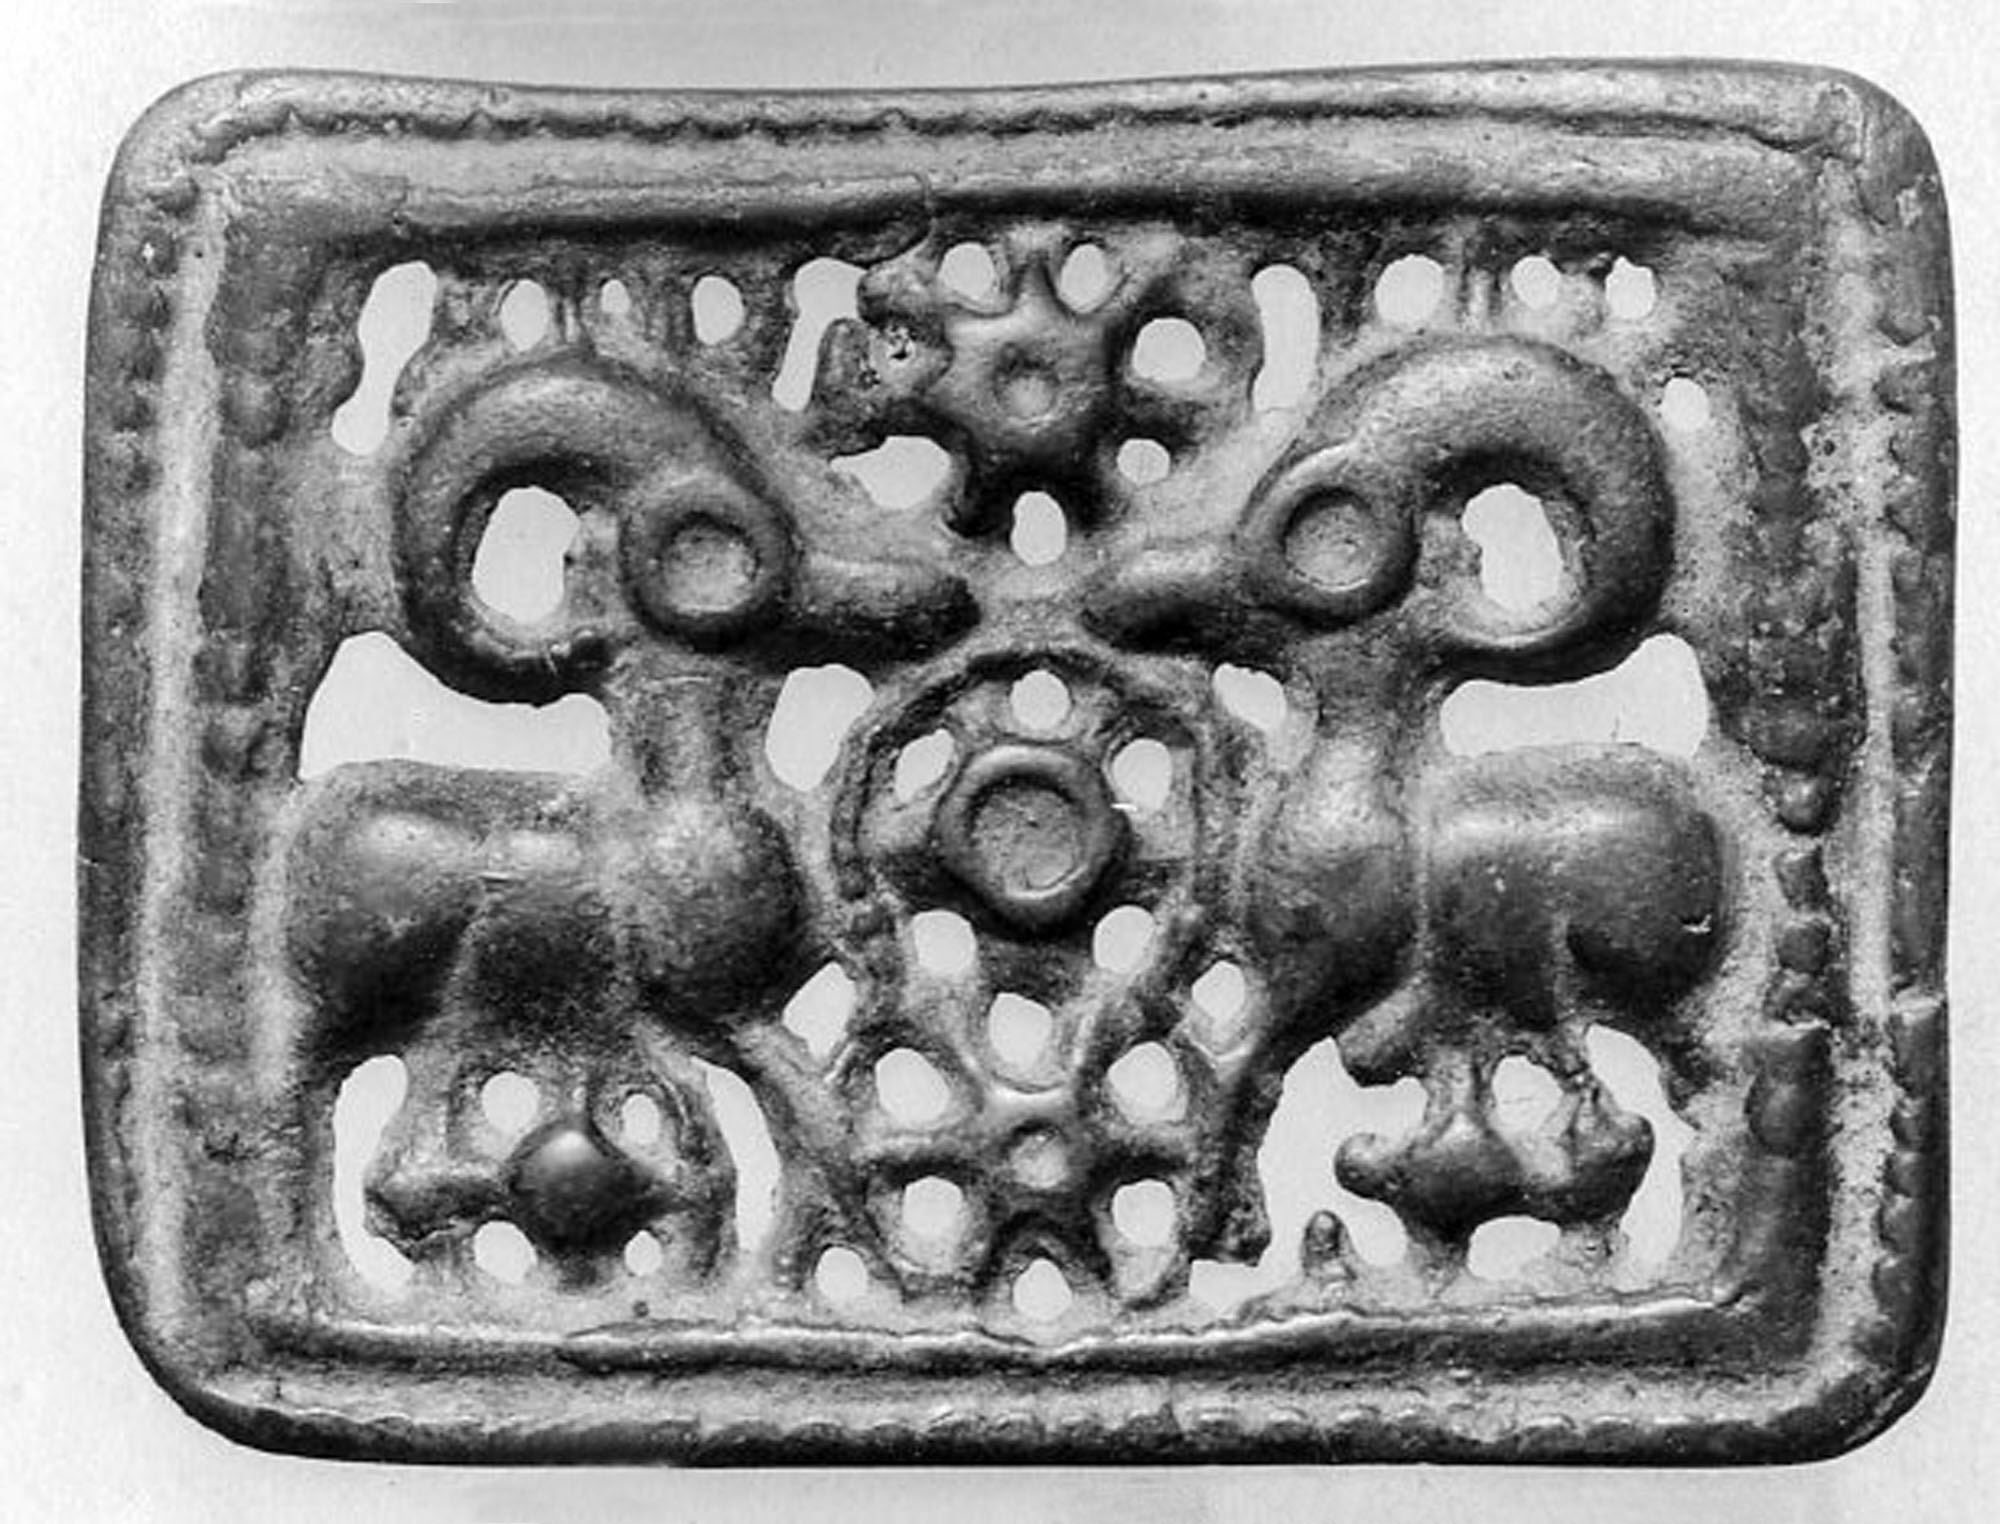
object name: plaque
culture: chinese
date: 206 BCE-250 CE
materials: bronze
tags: animals